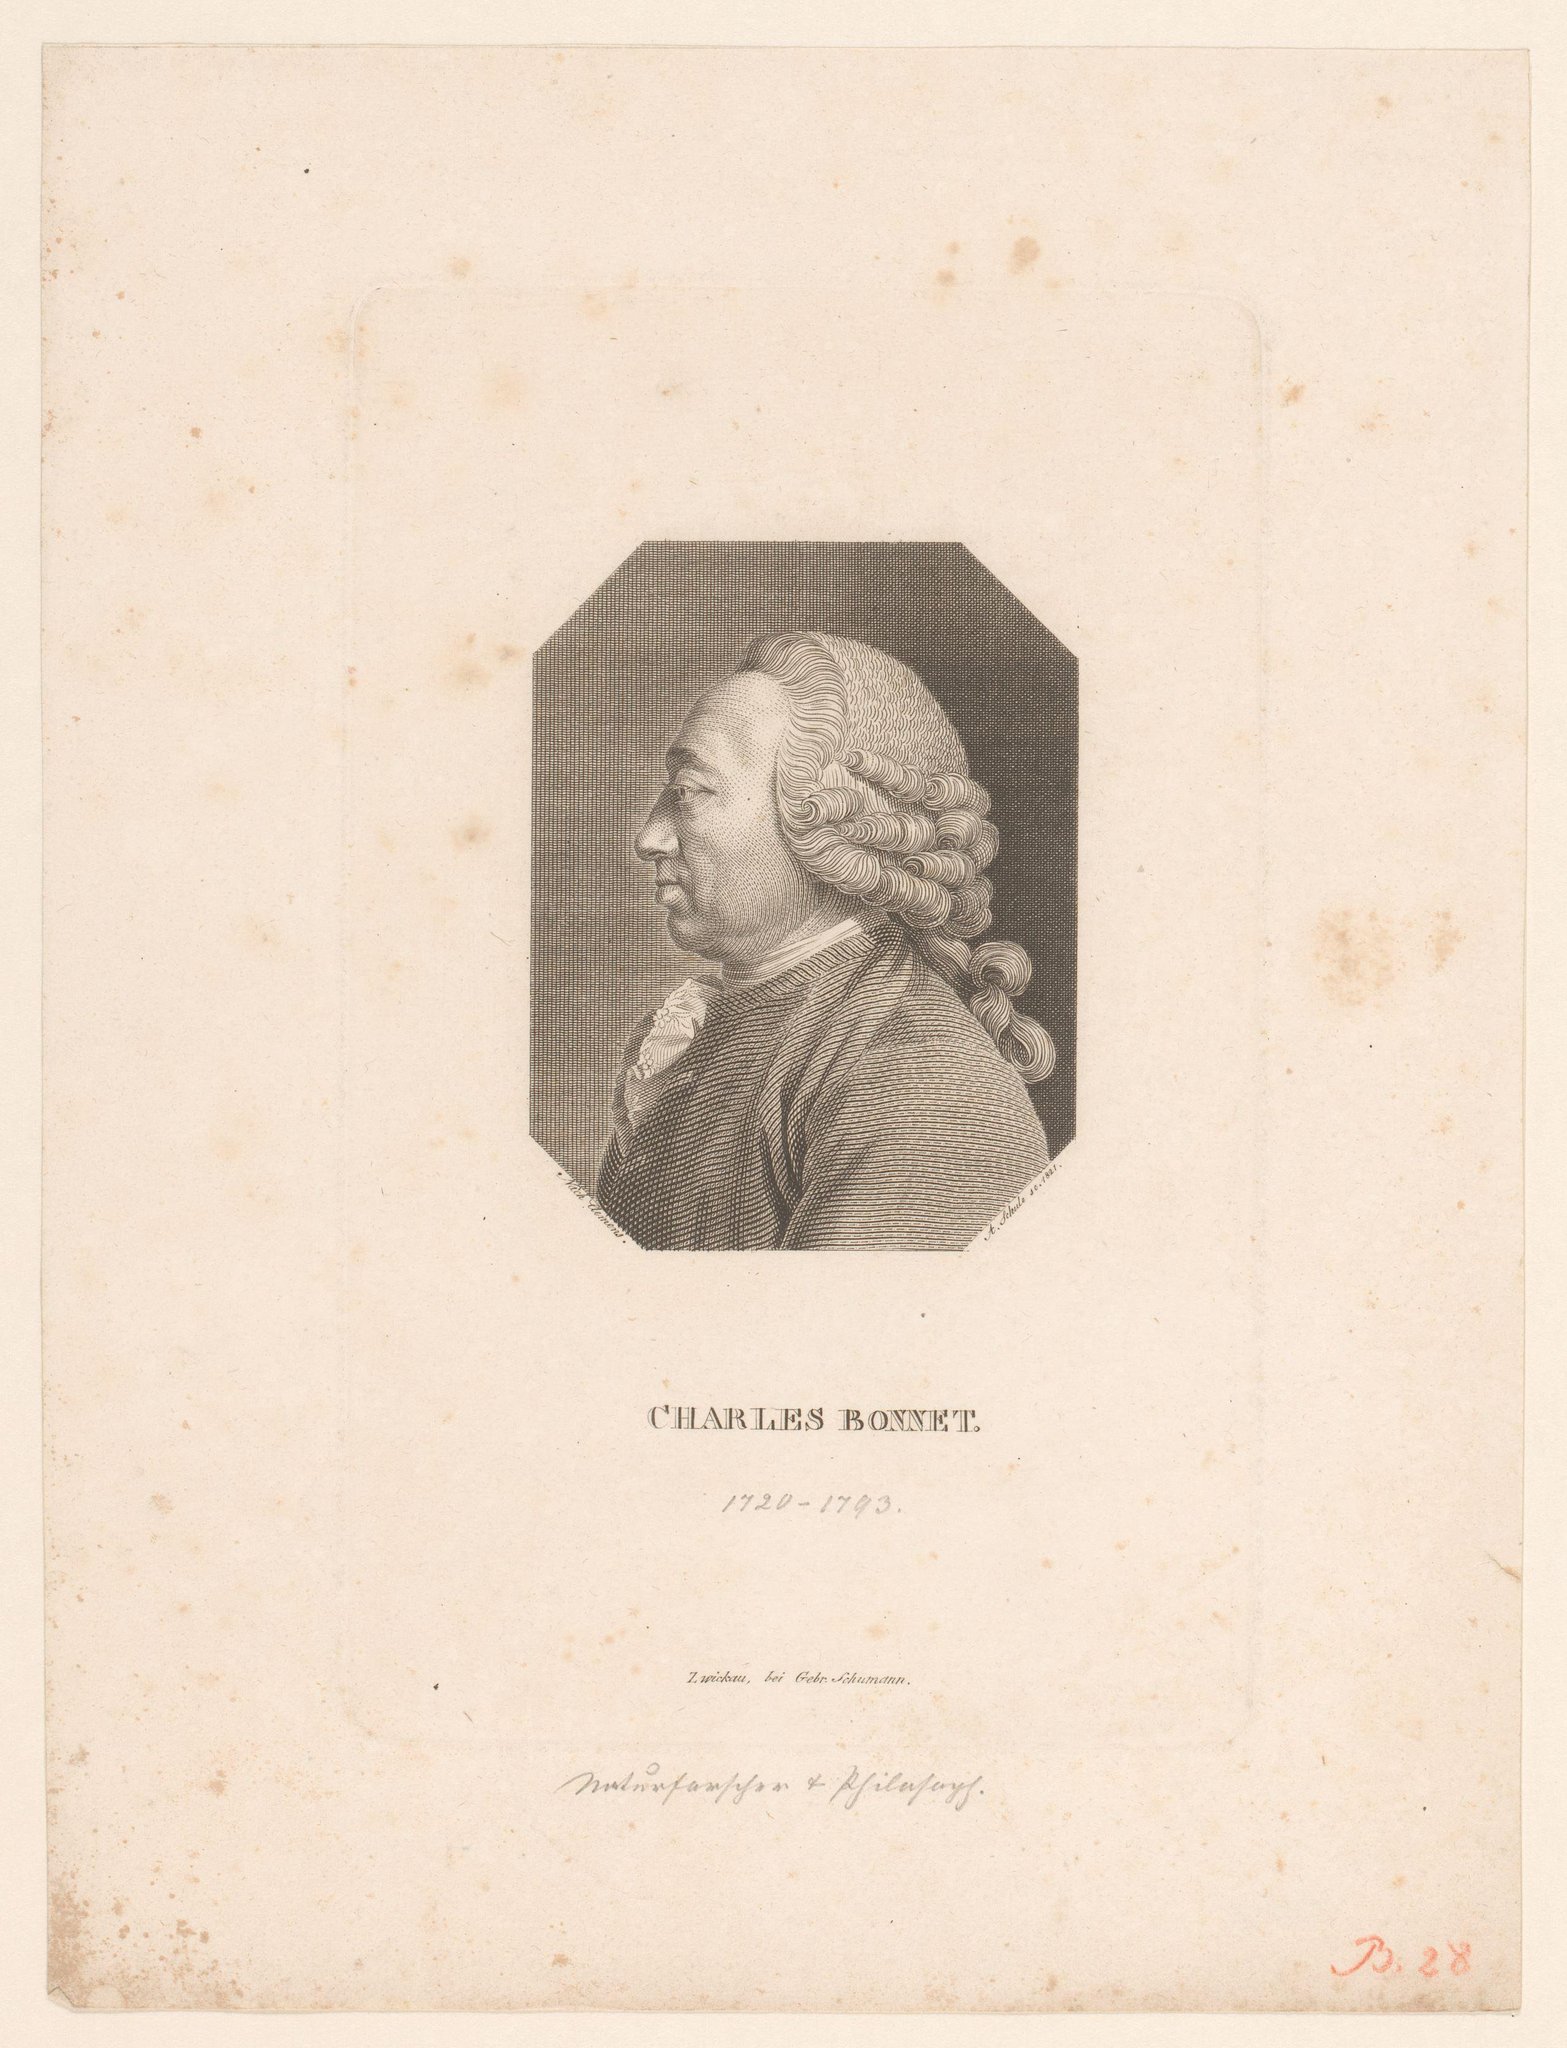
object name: print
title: Portret van Charles Bonnet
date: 1821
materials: paper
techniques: engraving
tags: historical persons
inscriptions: collector's mark: Lugt 2228